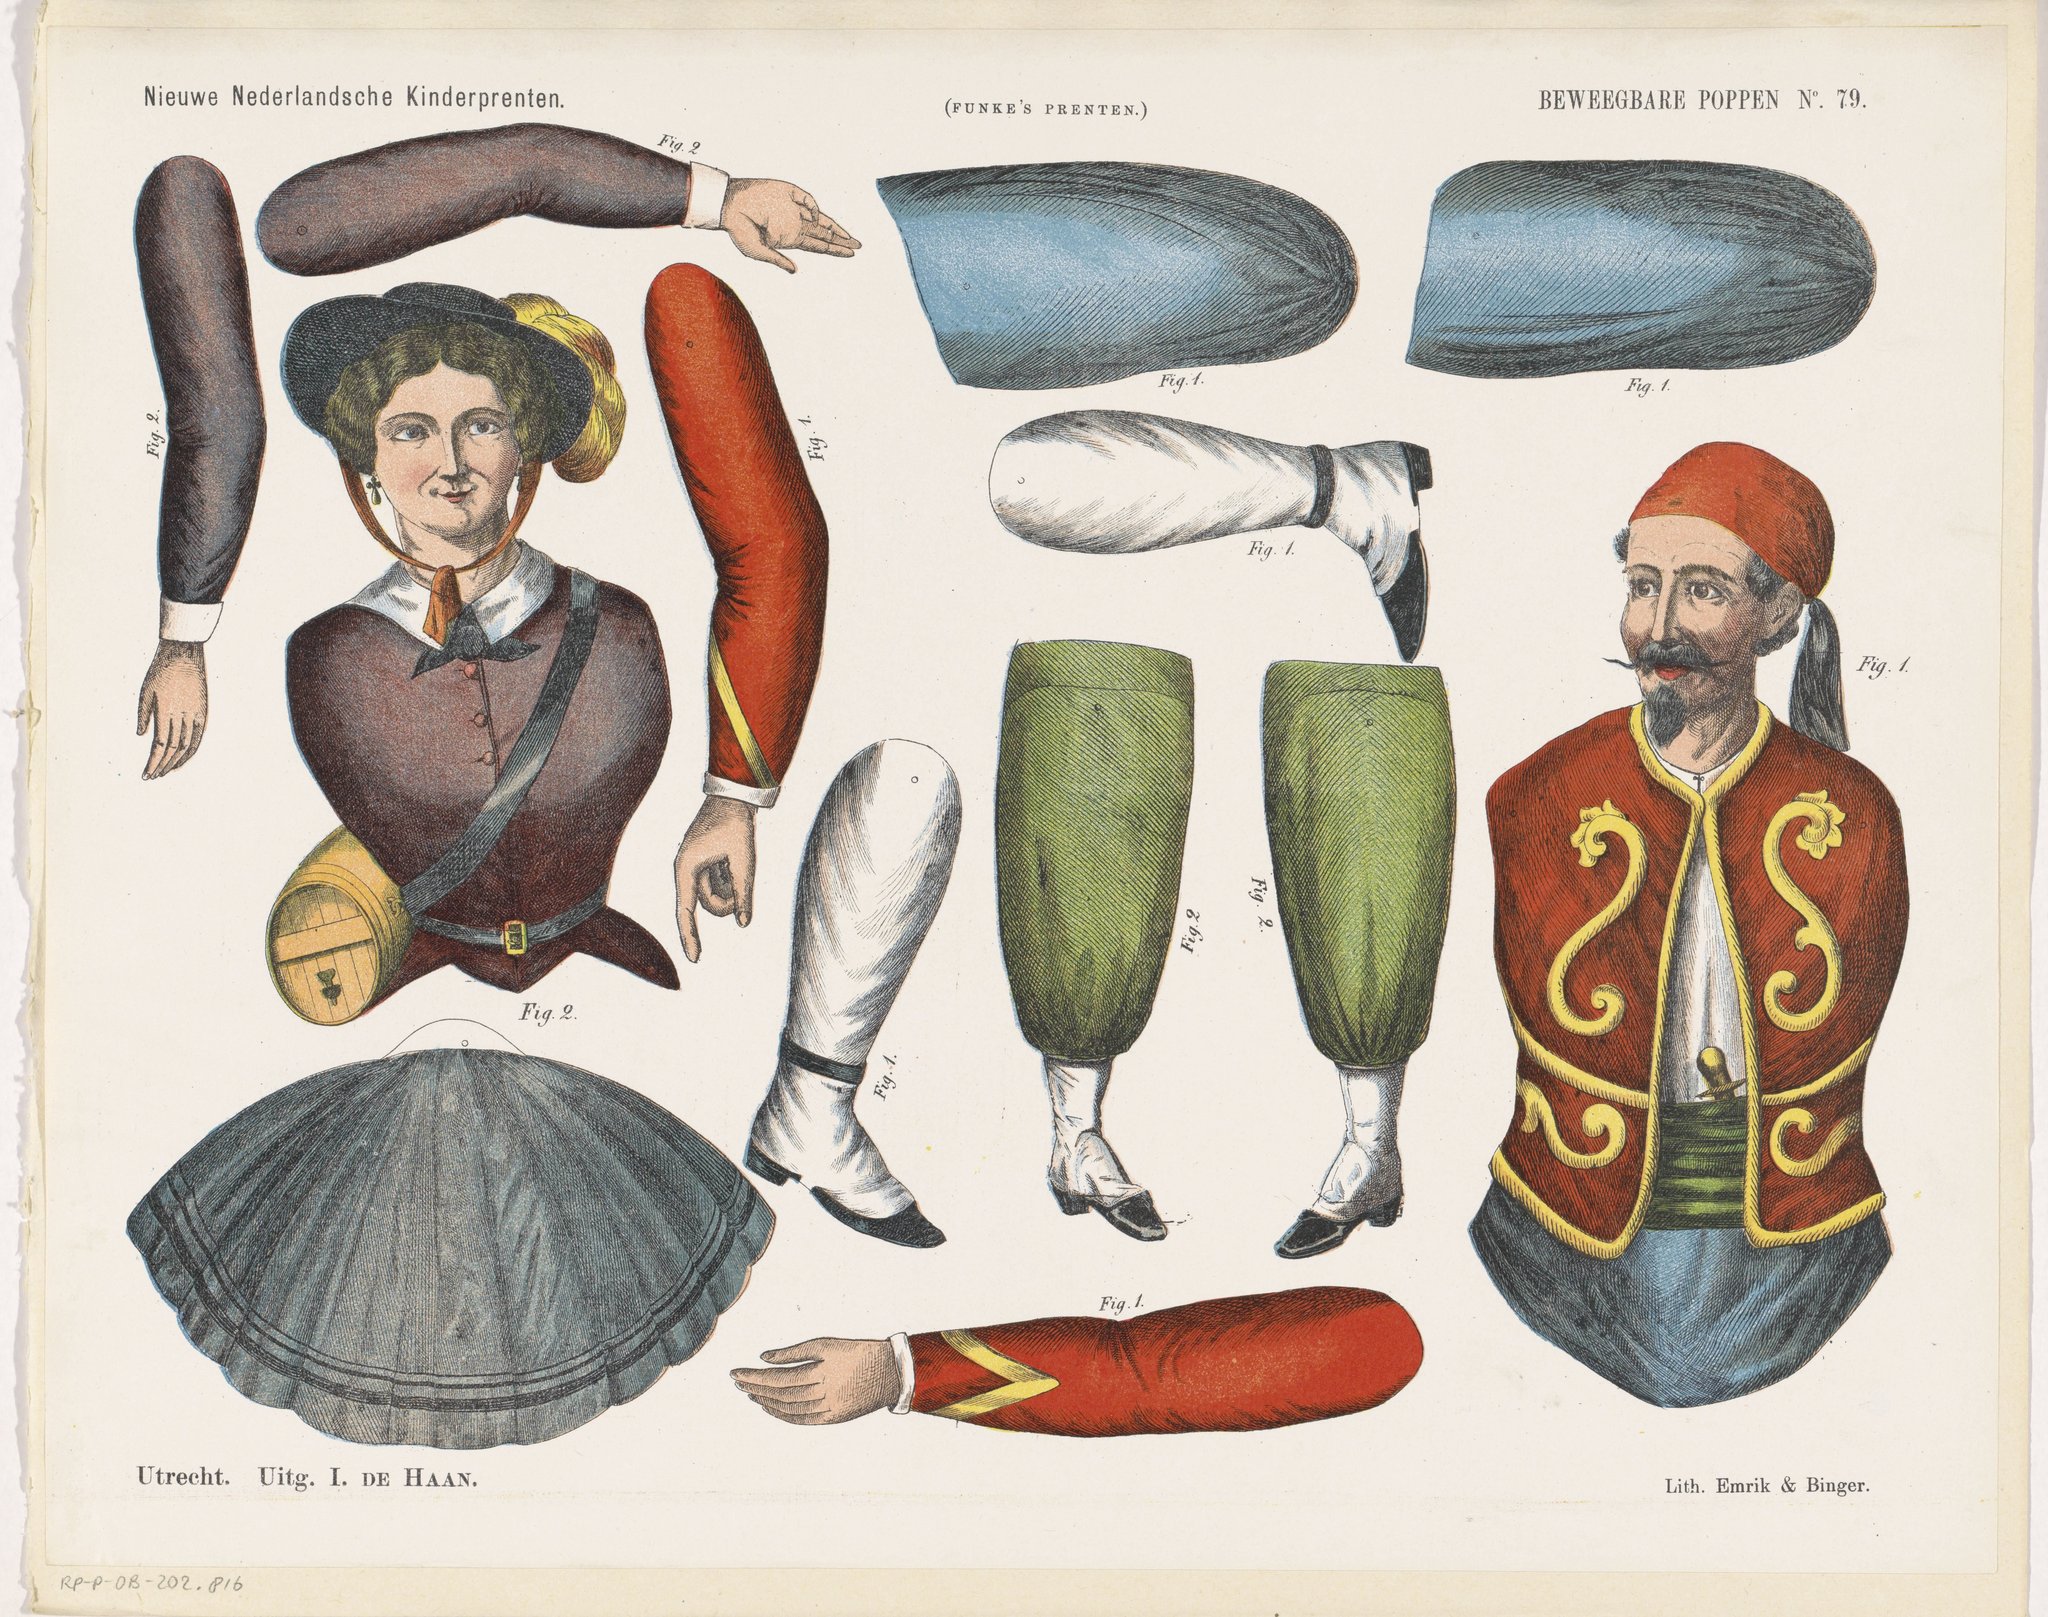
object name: popular print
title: Beweegbare poppen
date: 1875-1903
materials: paper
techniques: lithograph, letterpress printing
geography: utrecht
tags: puppet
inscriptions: collector's mark: Lugt 2760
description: Blad met 2 trekpoppen om uit te knippen. Links een vrouw met hoed en rok. Rechts een zouaaf (Franse soldaat). Genummerd rechtsboven: No. 79.